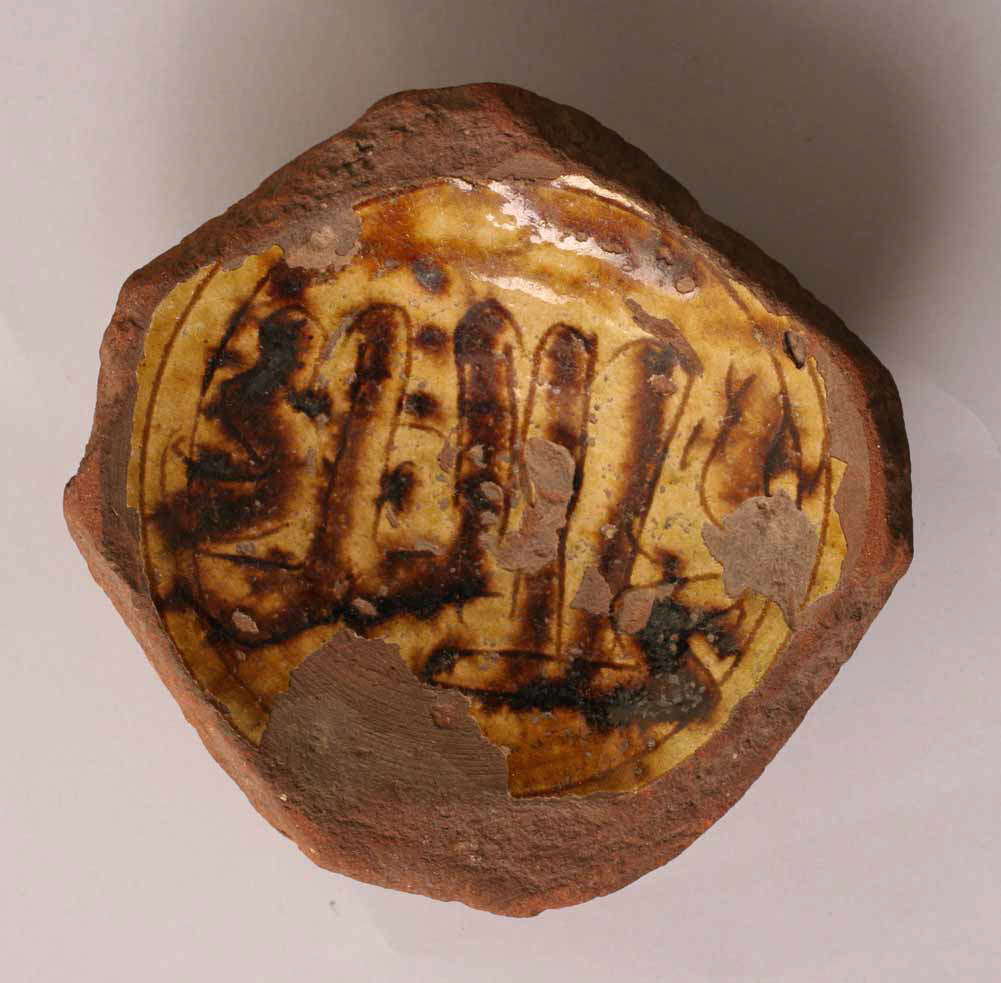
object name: fragment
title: Fragment of a Bowl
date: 1301-1500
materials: earthenware, glaze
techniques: coloring, incising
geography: egypt